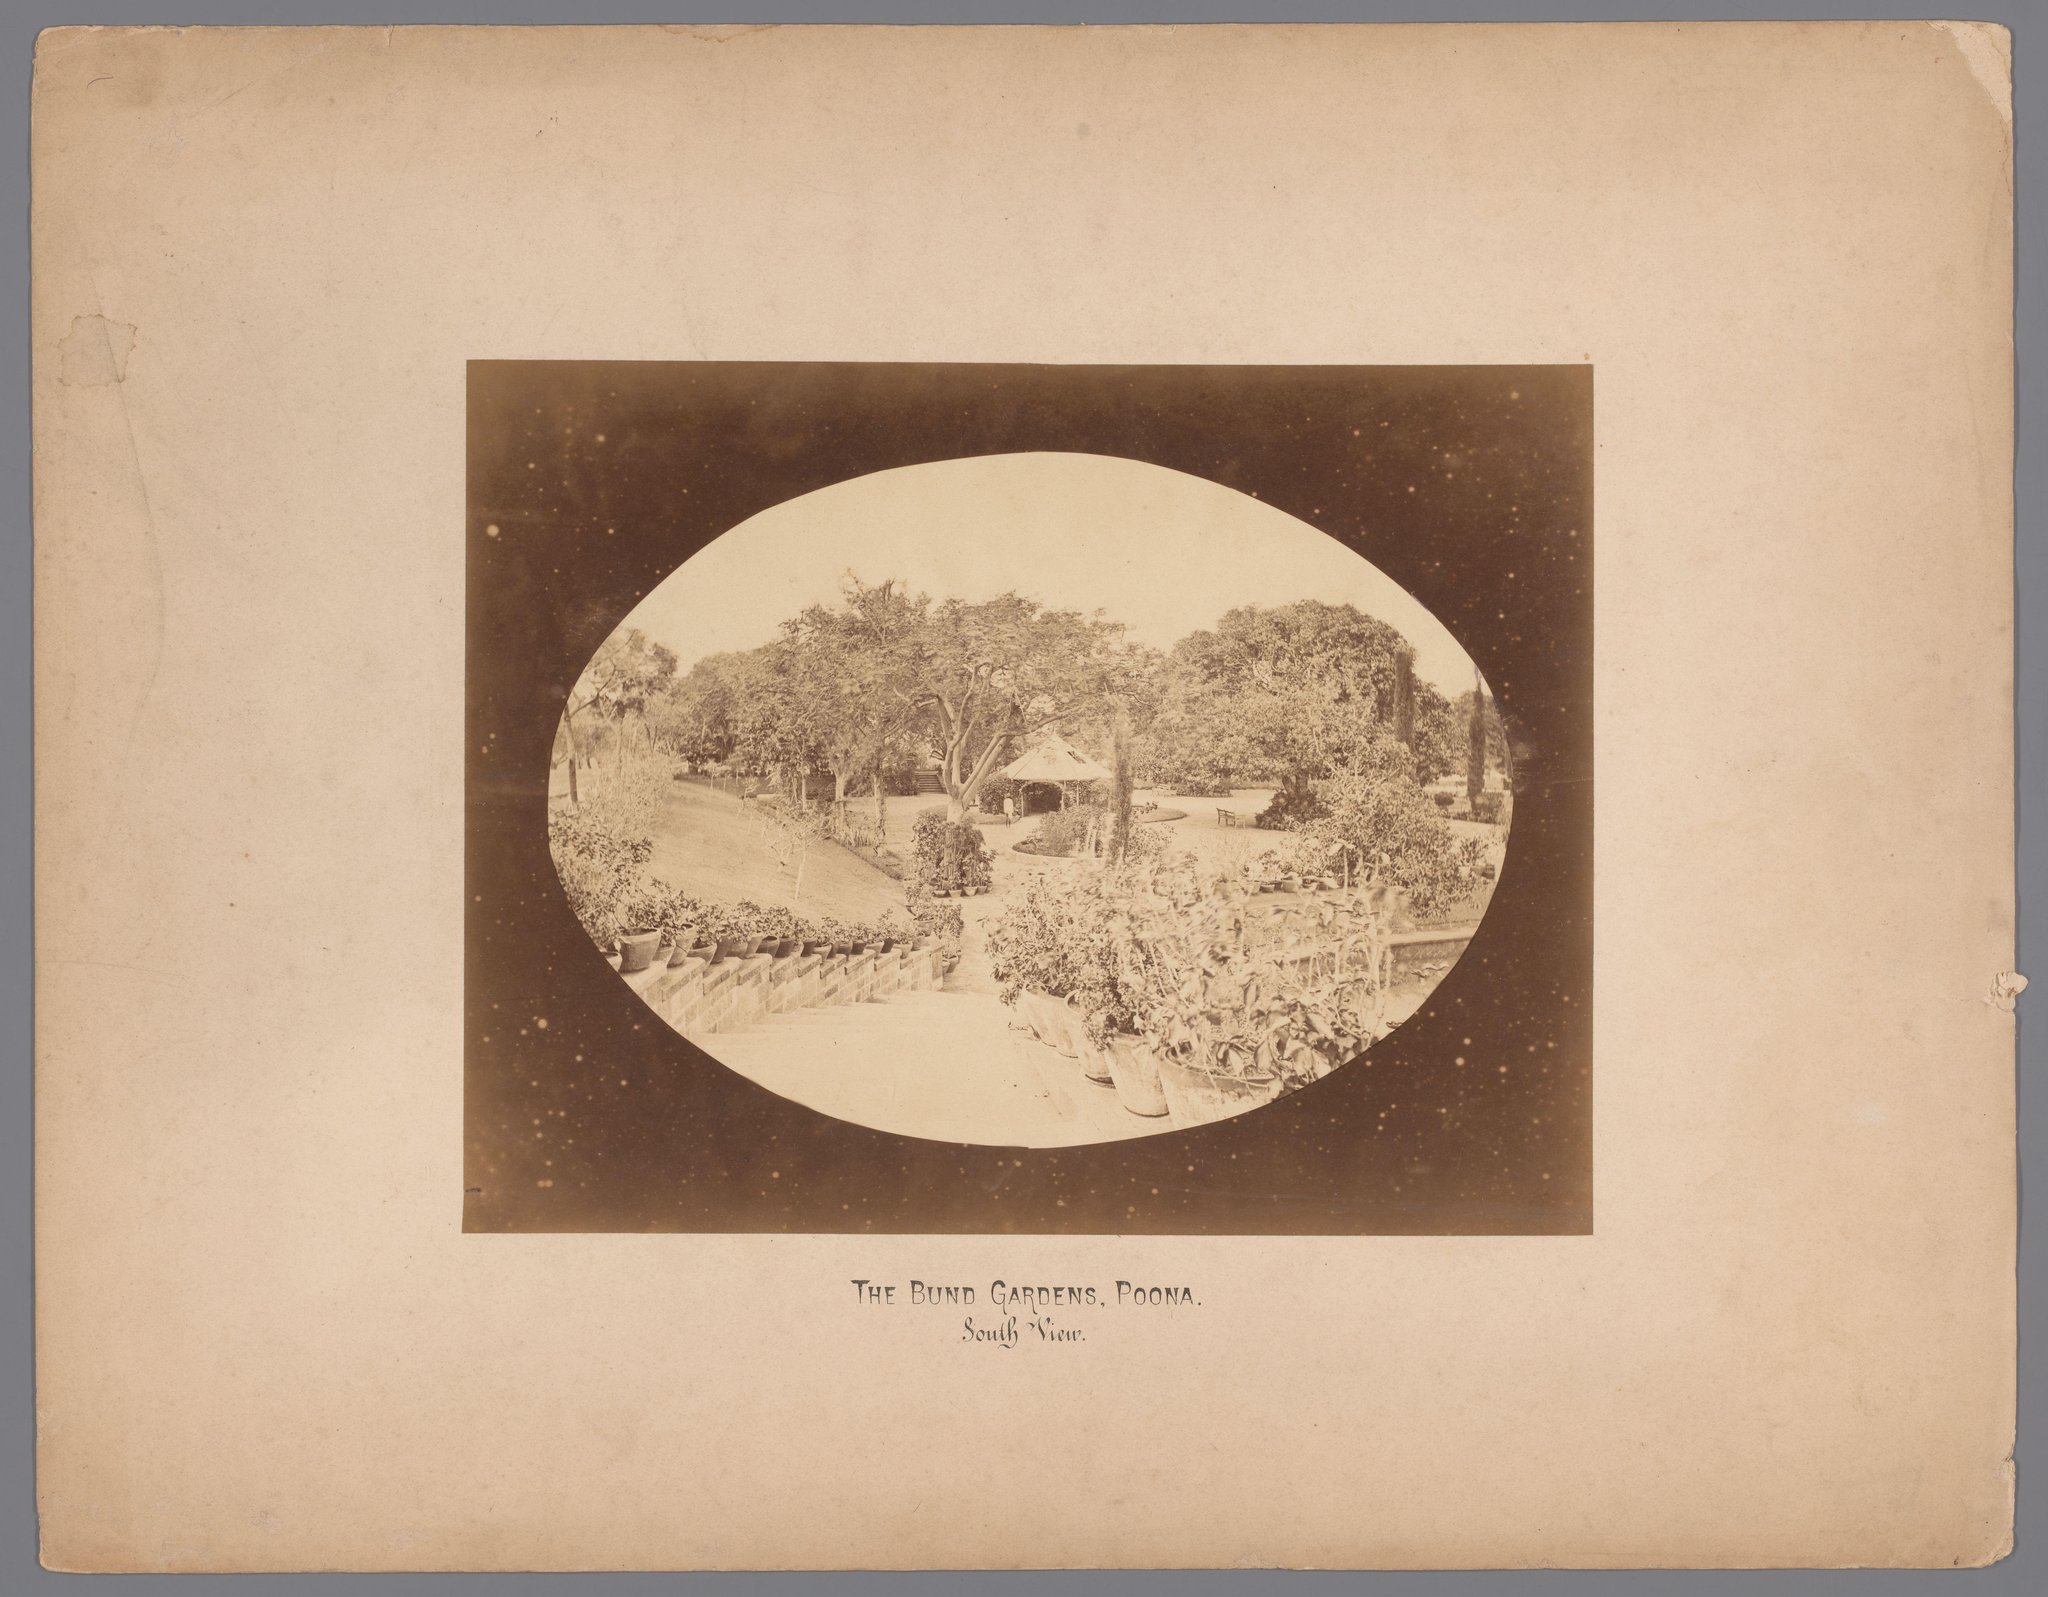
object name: photograph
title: The Fitzgerald bridge, Bund Gardens and River (...), Poona, India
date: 1875-1900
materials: cardboard, photographic support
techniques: albumen print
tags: india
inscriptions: inscription: ‘THE BUND GARDENS, POONA.//South View.’, inscription: ‘The Bund Gardens - Poona//South View’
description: Ovale foto van een brug met rivier en links een park. Poona, ook wel Pune en Puna en vroeger Punavadi is een Indiase stad niet ver van Bombay in de West-Ghats. De stad is gelegen in het gelijknamige district Poona.